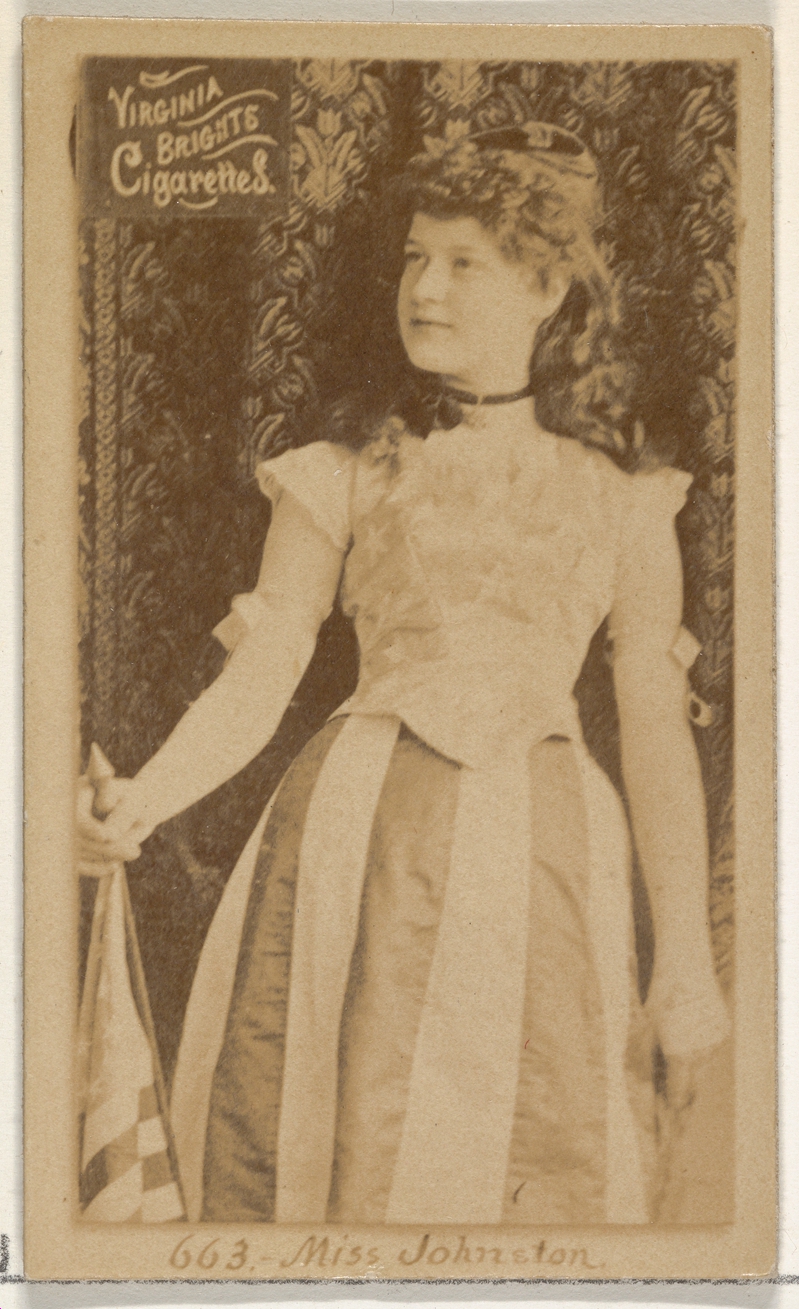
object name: photograph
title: Card 663, Miss Johnston, from the Actors and Actresses series (N45, Type 2) for Virginia Brights Cigarettes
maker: allen & ginter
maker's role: publisher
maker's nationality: american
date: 1888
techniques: albumen silver print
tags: portraits,women,actresses